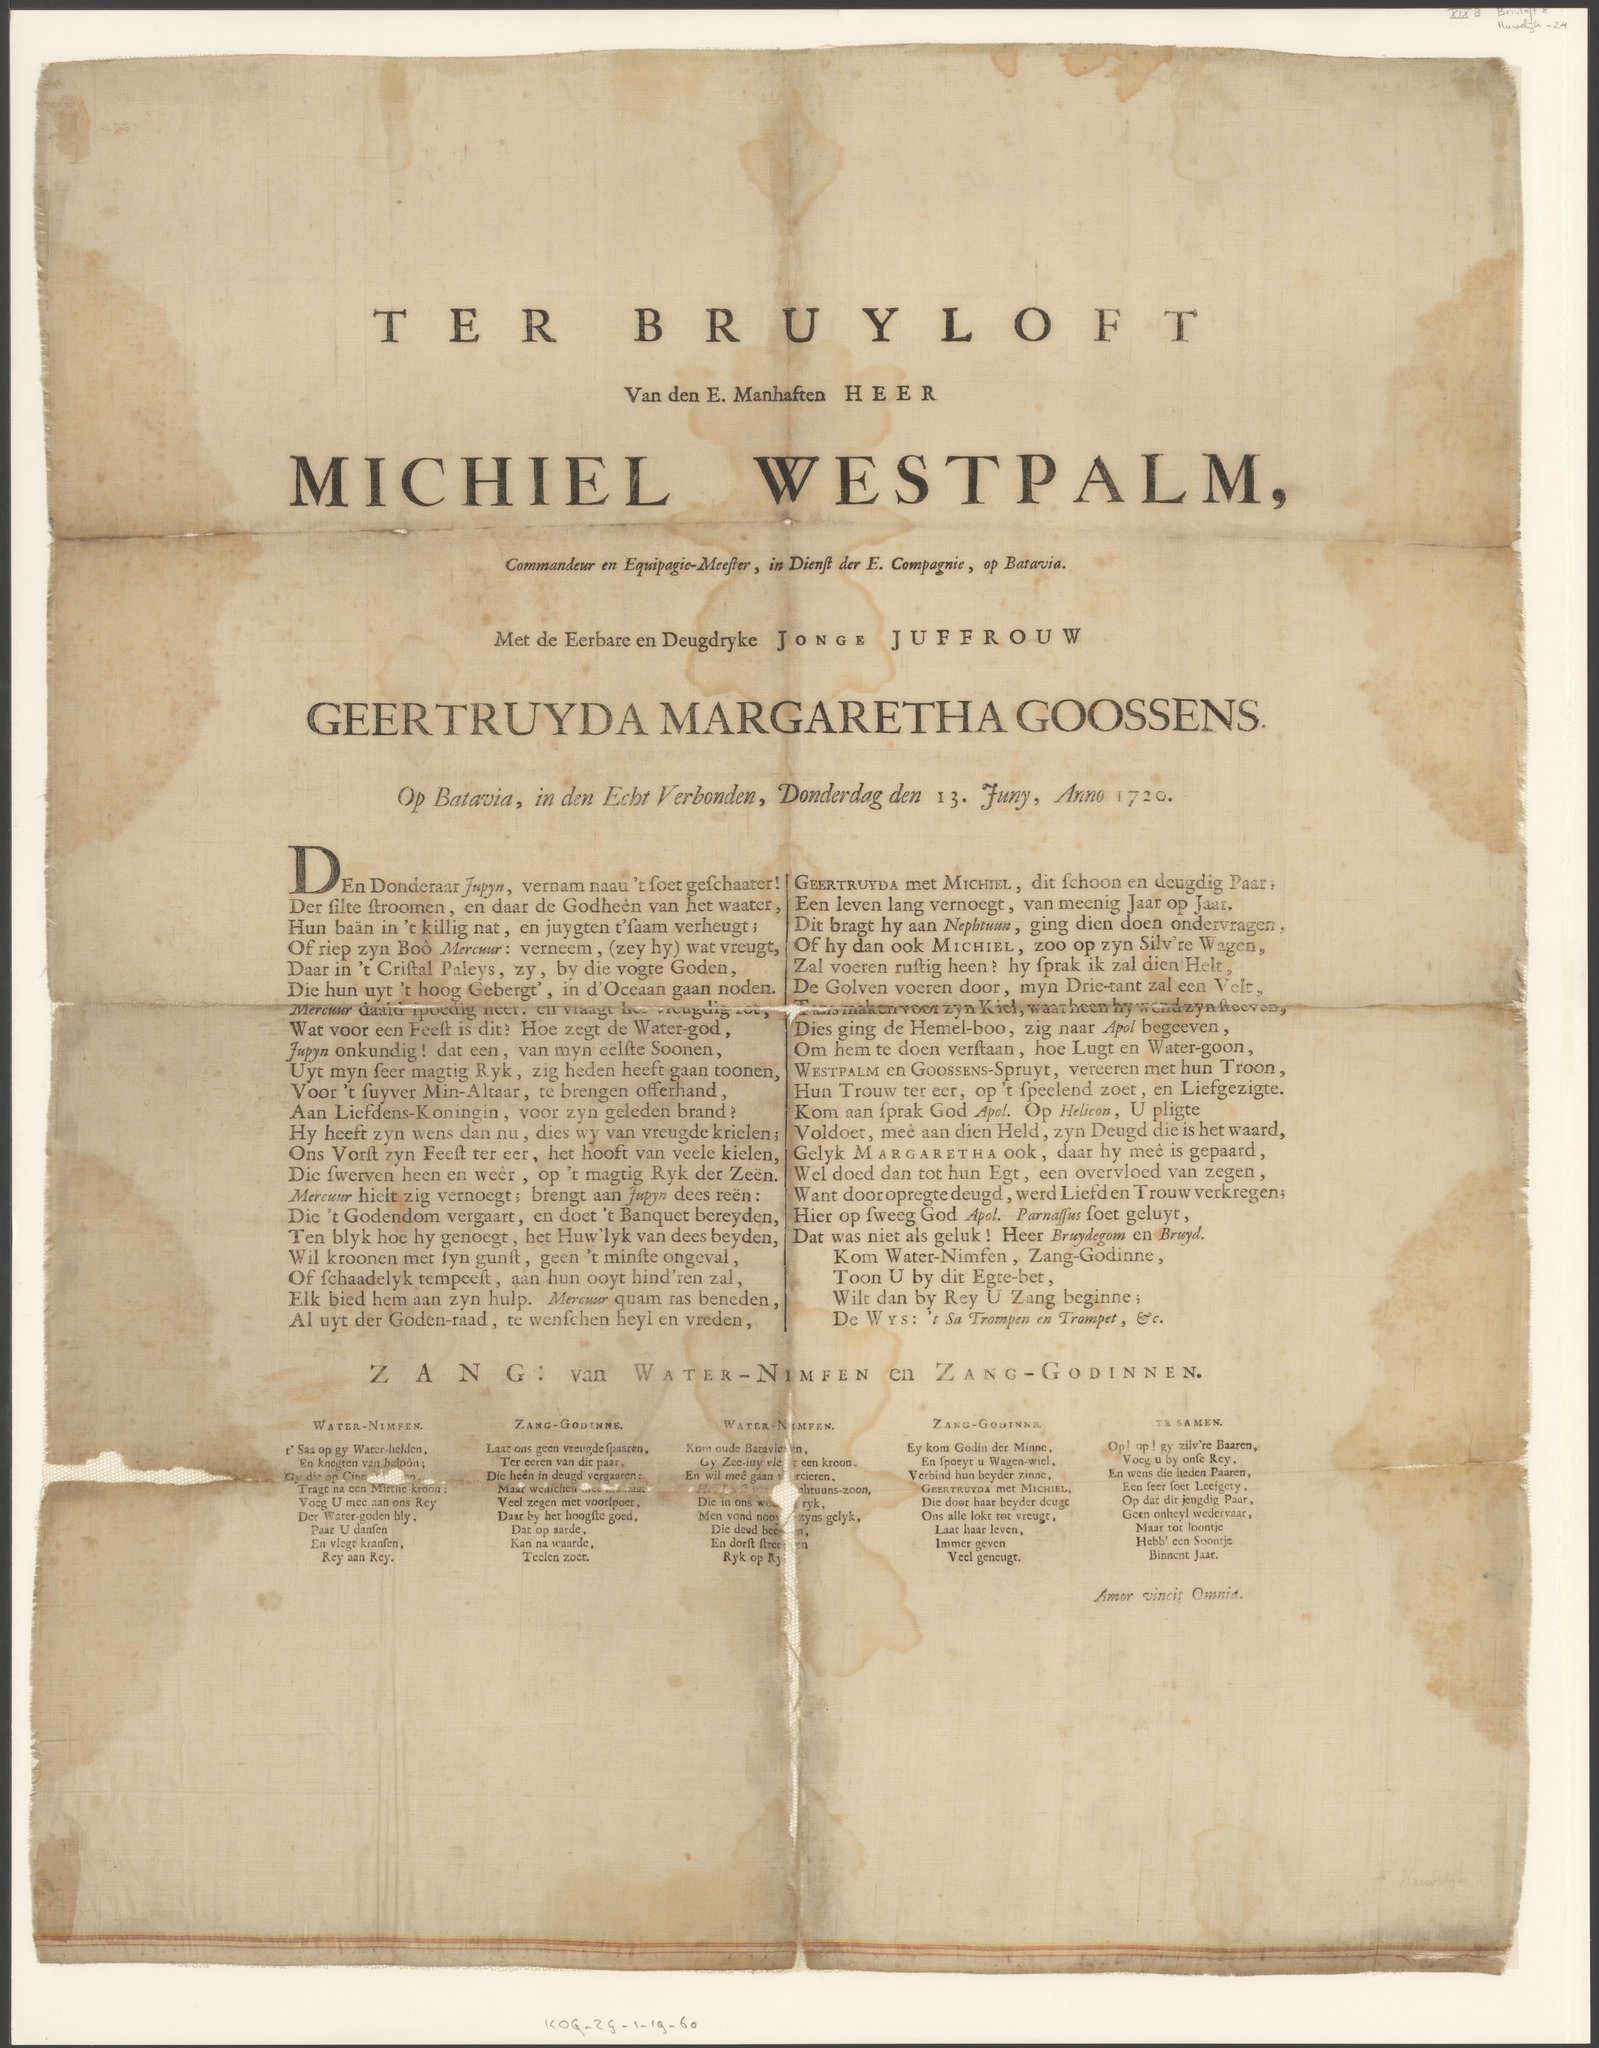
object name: text sheet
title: Ter Bruyloft van den E. Manhaften Heer Michiel Westpalm, Commandeur en Equipagie-Meester, in Dienst der E. Compagnie, op Batavia. Met de Eerbare en Deugdryke Jonge Juffrouw Geertruyda Margaretha Goossens. Op Batavia, in den Echt Verbonden, Donderdag den 13. Juny, Anno 1720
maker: Anonymous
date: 1720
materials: textile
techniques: letterpress printing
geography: batavia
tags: batavia, (civil) marriage ceremonies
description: Vers ter gelegenheid van het huwelijk tussen Michiel Westpalm en Geertruyda Margaretha Goossens, te Batavia, op 13 juni 1720. Vers in twee kolommen, met onderaan de vijf verzen zang van de waternimfen en de zanggodin. Onderwerpsrubrieken binnen de Atlas Zeden en Gewoonten: Des Menschen Begin, Midden en Einde. Bruiloft en huwelijk.